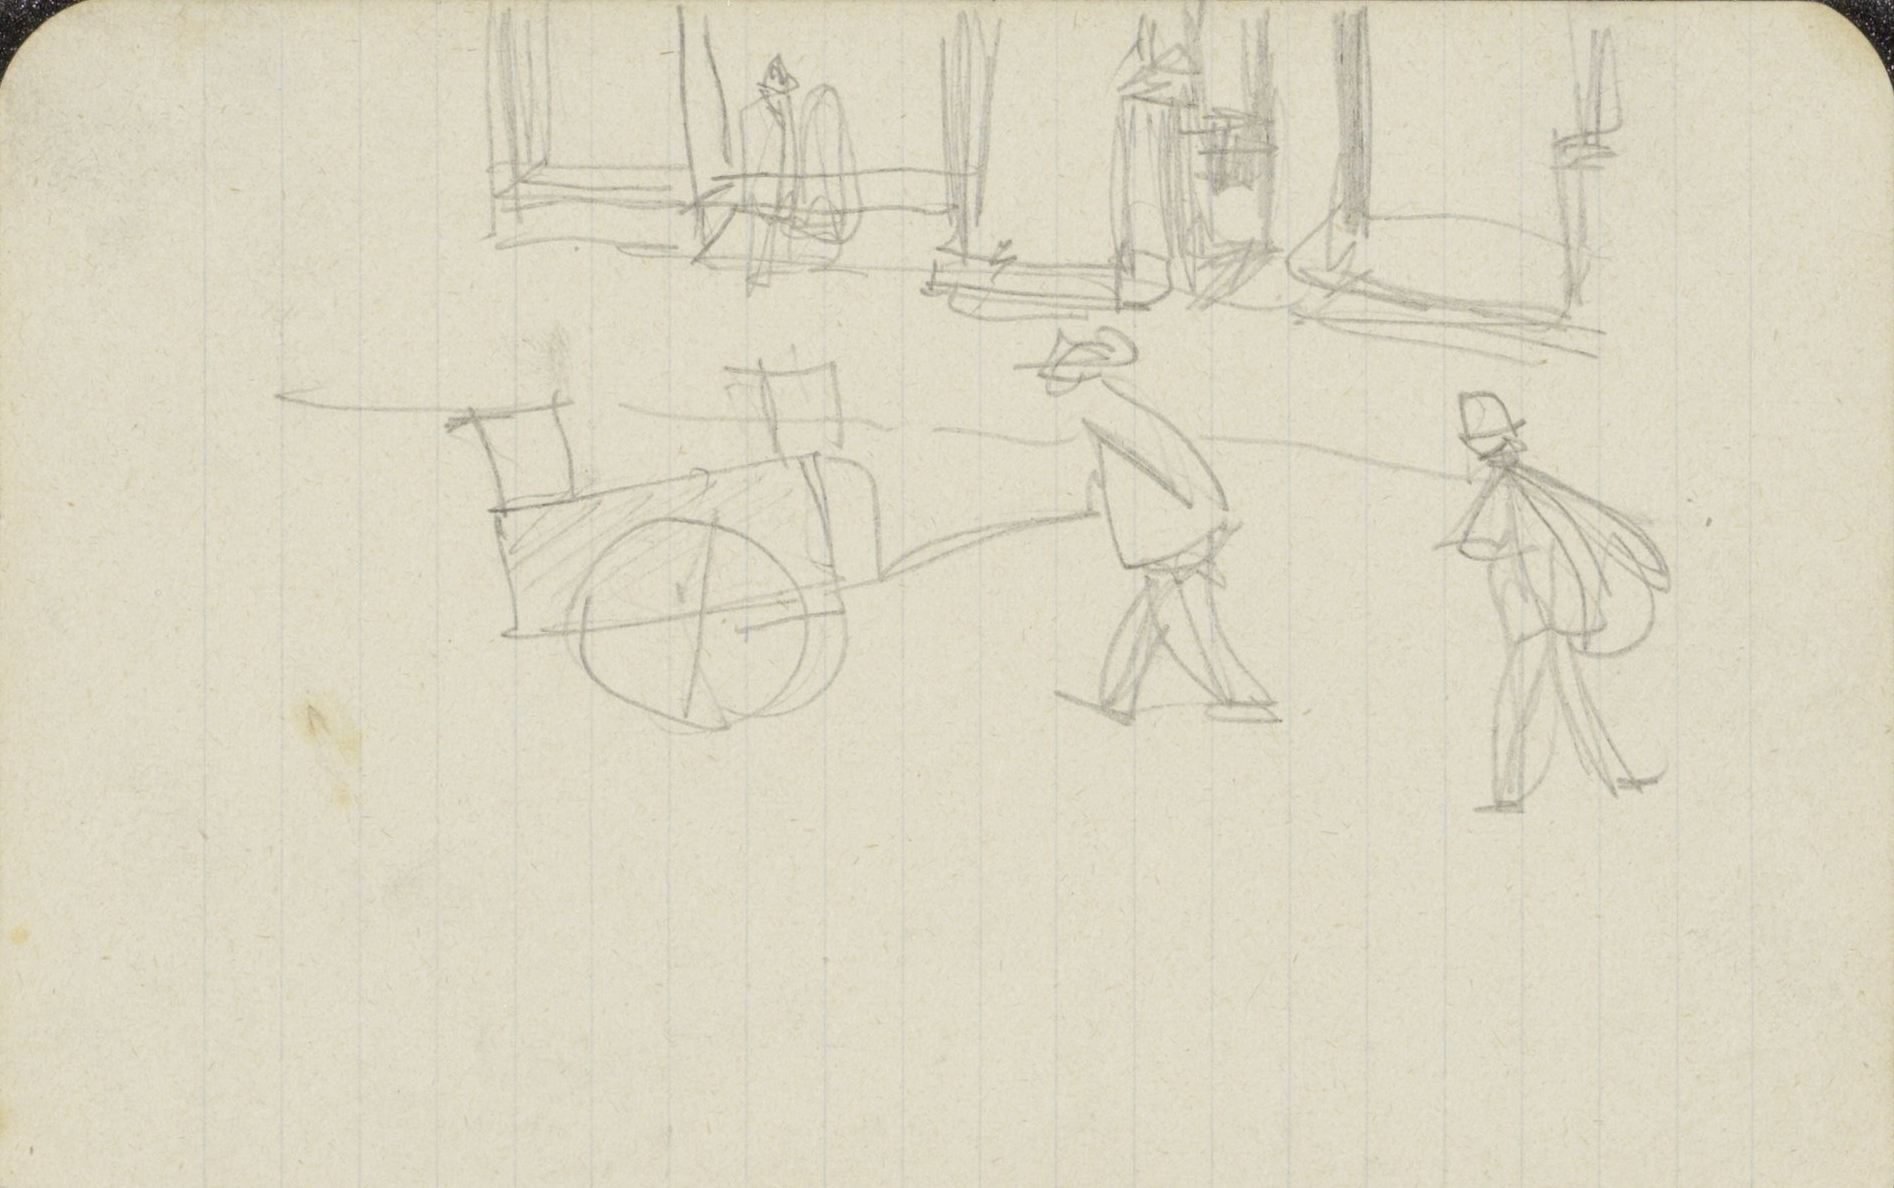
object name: drawing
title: Twee uitdragers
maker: george hendrik breitner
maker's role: draughtsman, painter, print maker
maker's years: 1857-1923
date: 1873-1923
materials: pencil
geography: amsterdam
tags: hand-cart, urban housing, carrying something in basket, bag, rucksack, etc.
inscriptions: collector's mark: Lugt 2228, workshop stamp: Lugt 291d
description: Een man met een handkar en een man met een zak. Op de achtergrond gebouwen.